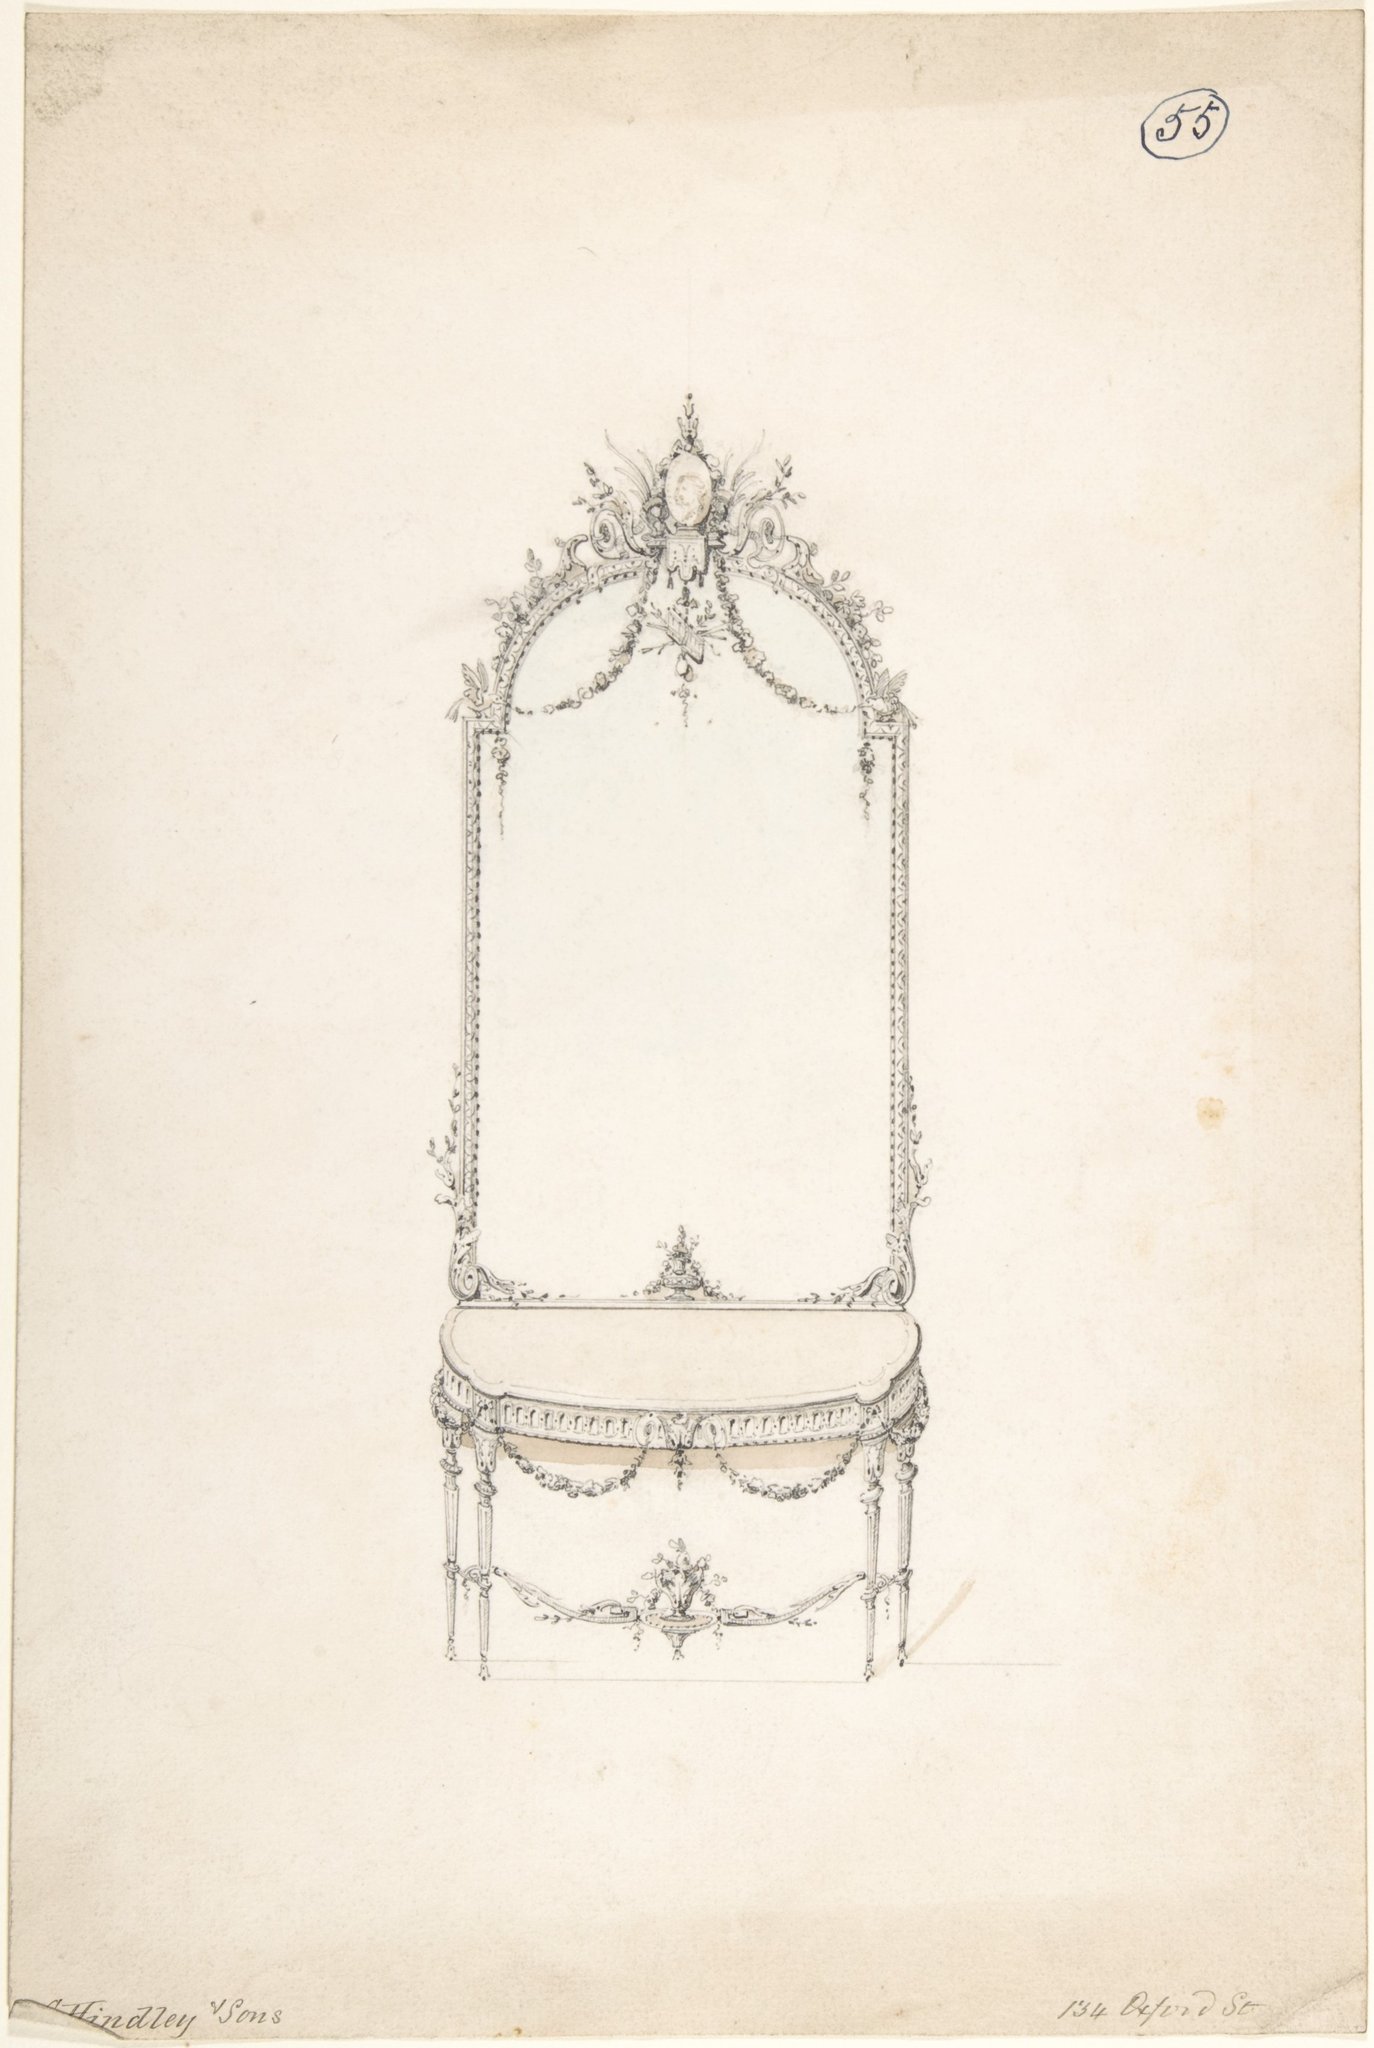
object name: drawing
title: Design for a Side Table and Mirror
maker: charles hindley and sons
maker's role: artist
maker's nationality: british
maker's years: 1841-1917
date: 1841-1884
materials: graphite, watercolor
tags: garlands,tables,mirrors